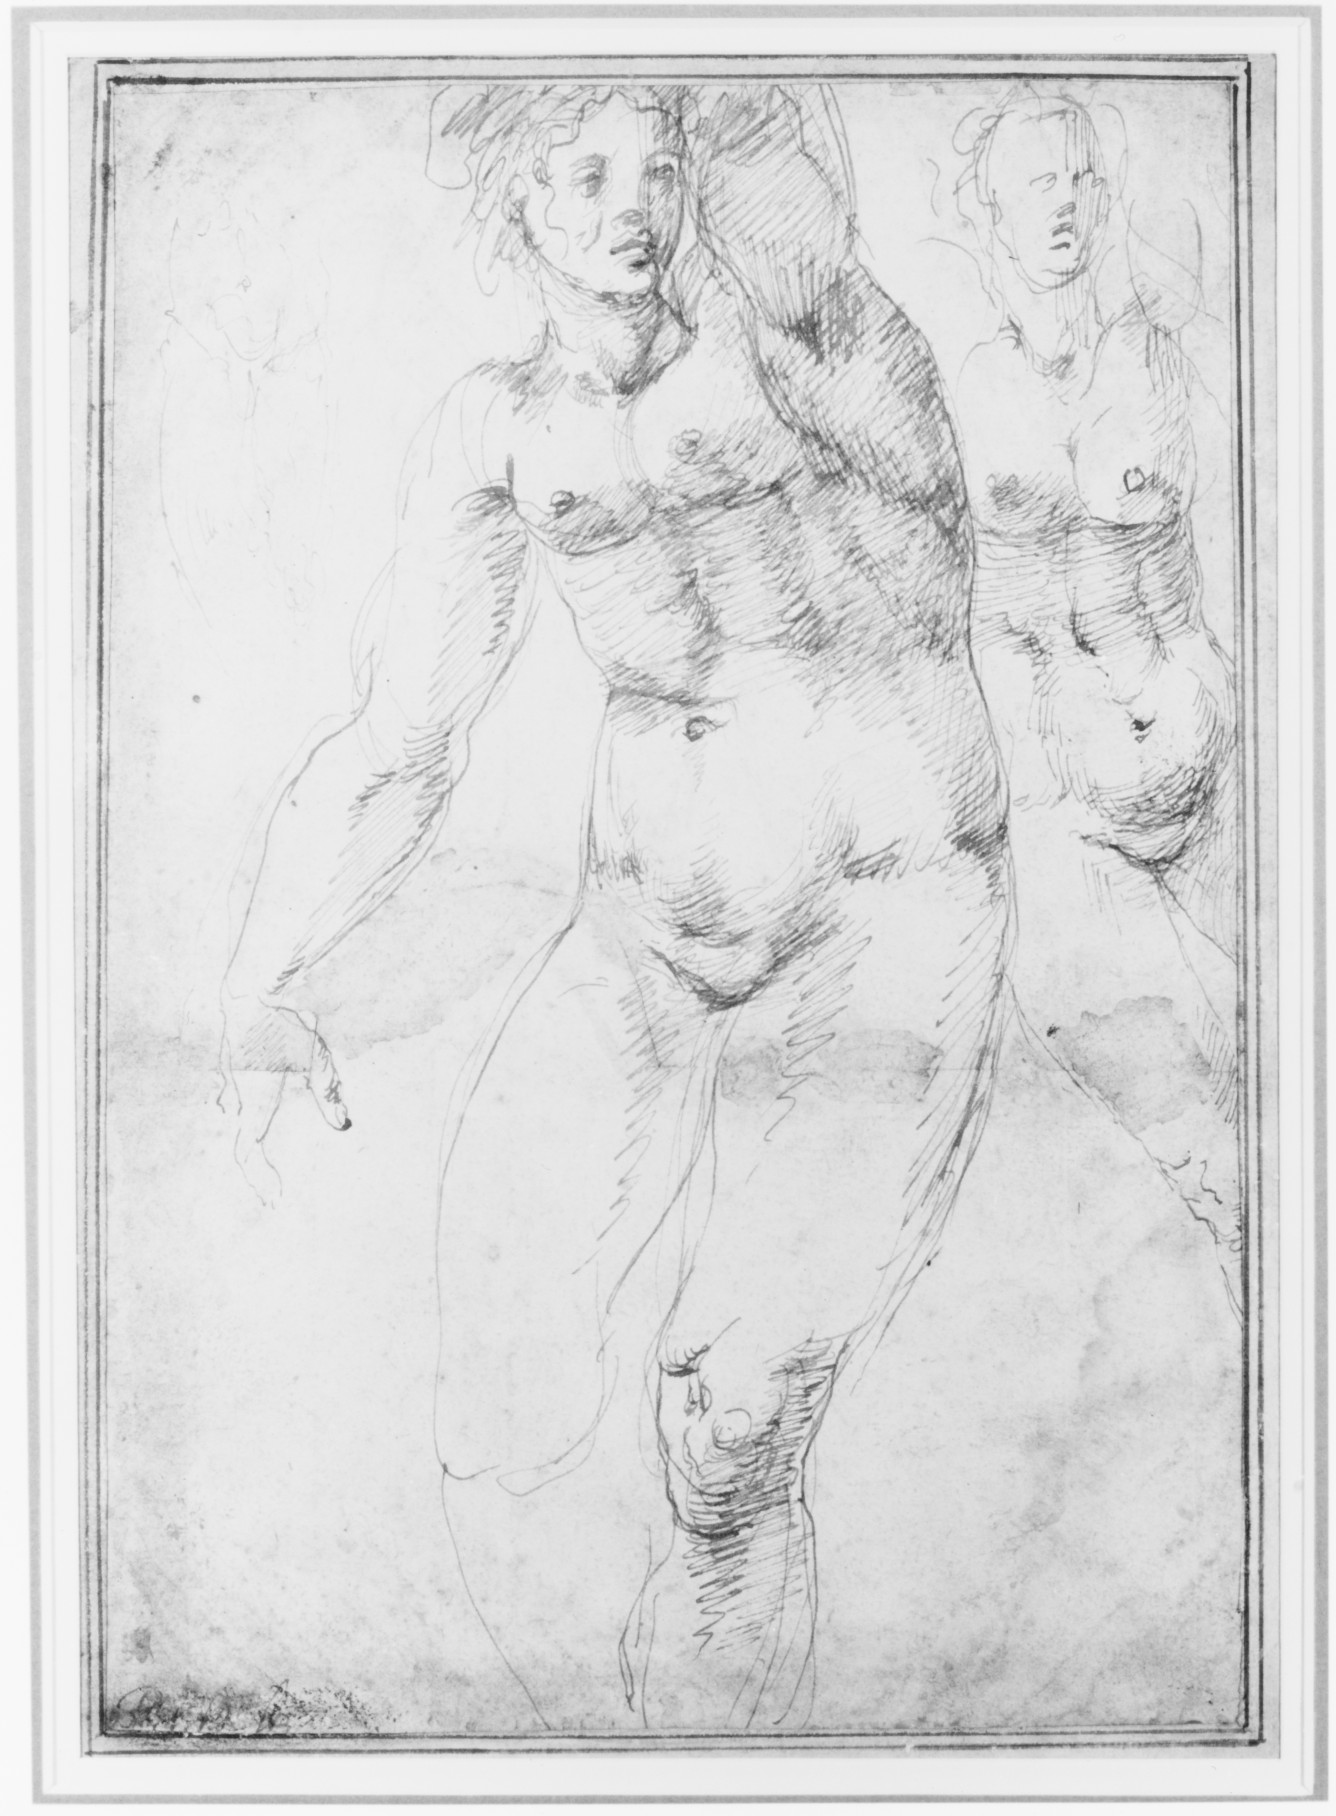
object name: drawing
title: Studies for a Nude Woman Seen from the Front (recto); Four Standing Male Nudes, Venus, and Cupid (verso)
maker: anonymous, italian, florentine, 16th century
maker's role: artist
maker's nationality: italian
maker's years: 1500-1600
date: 1501-1600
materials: ink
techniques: pen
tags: male nudes,female nudes